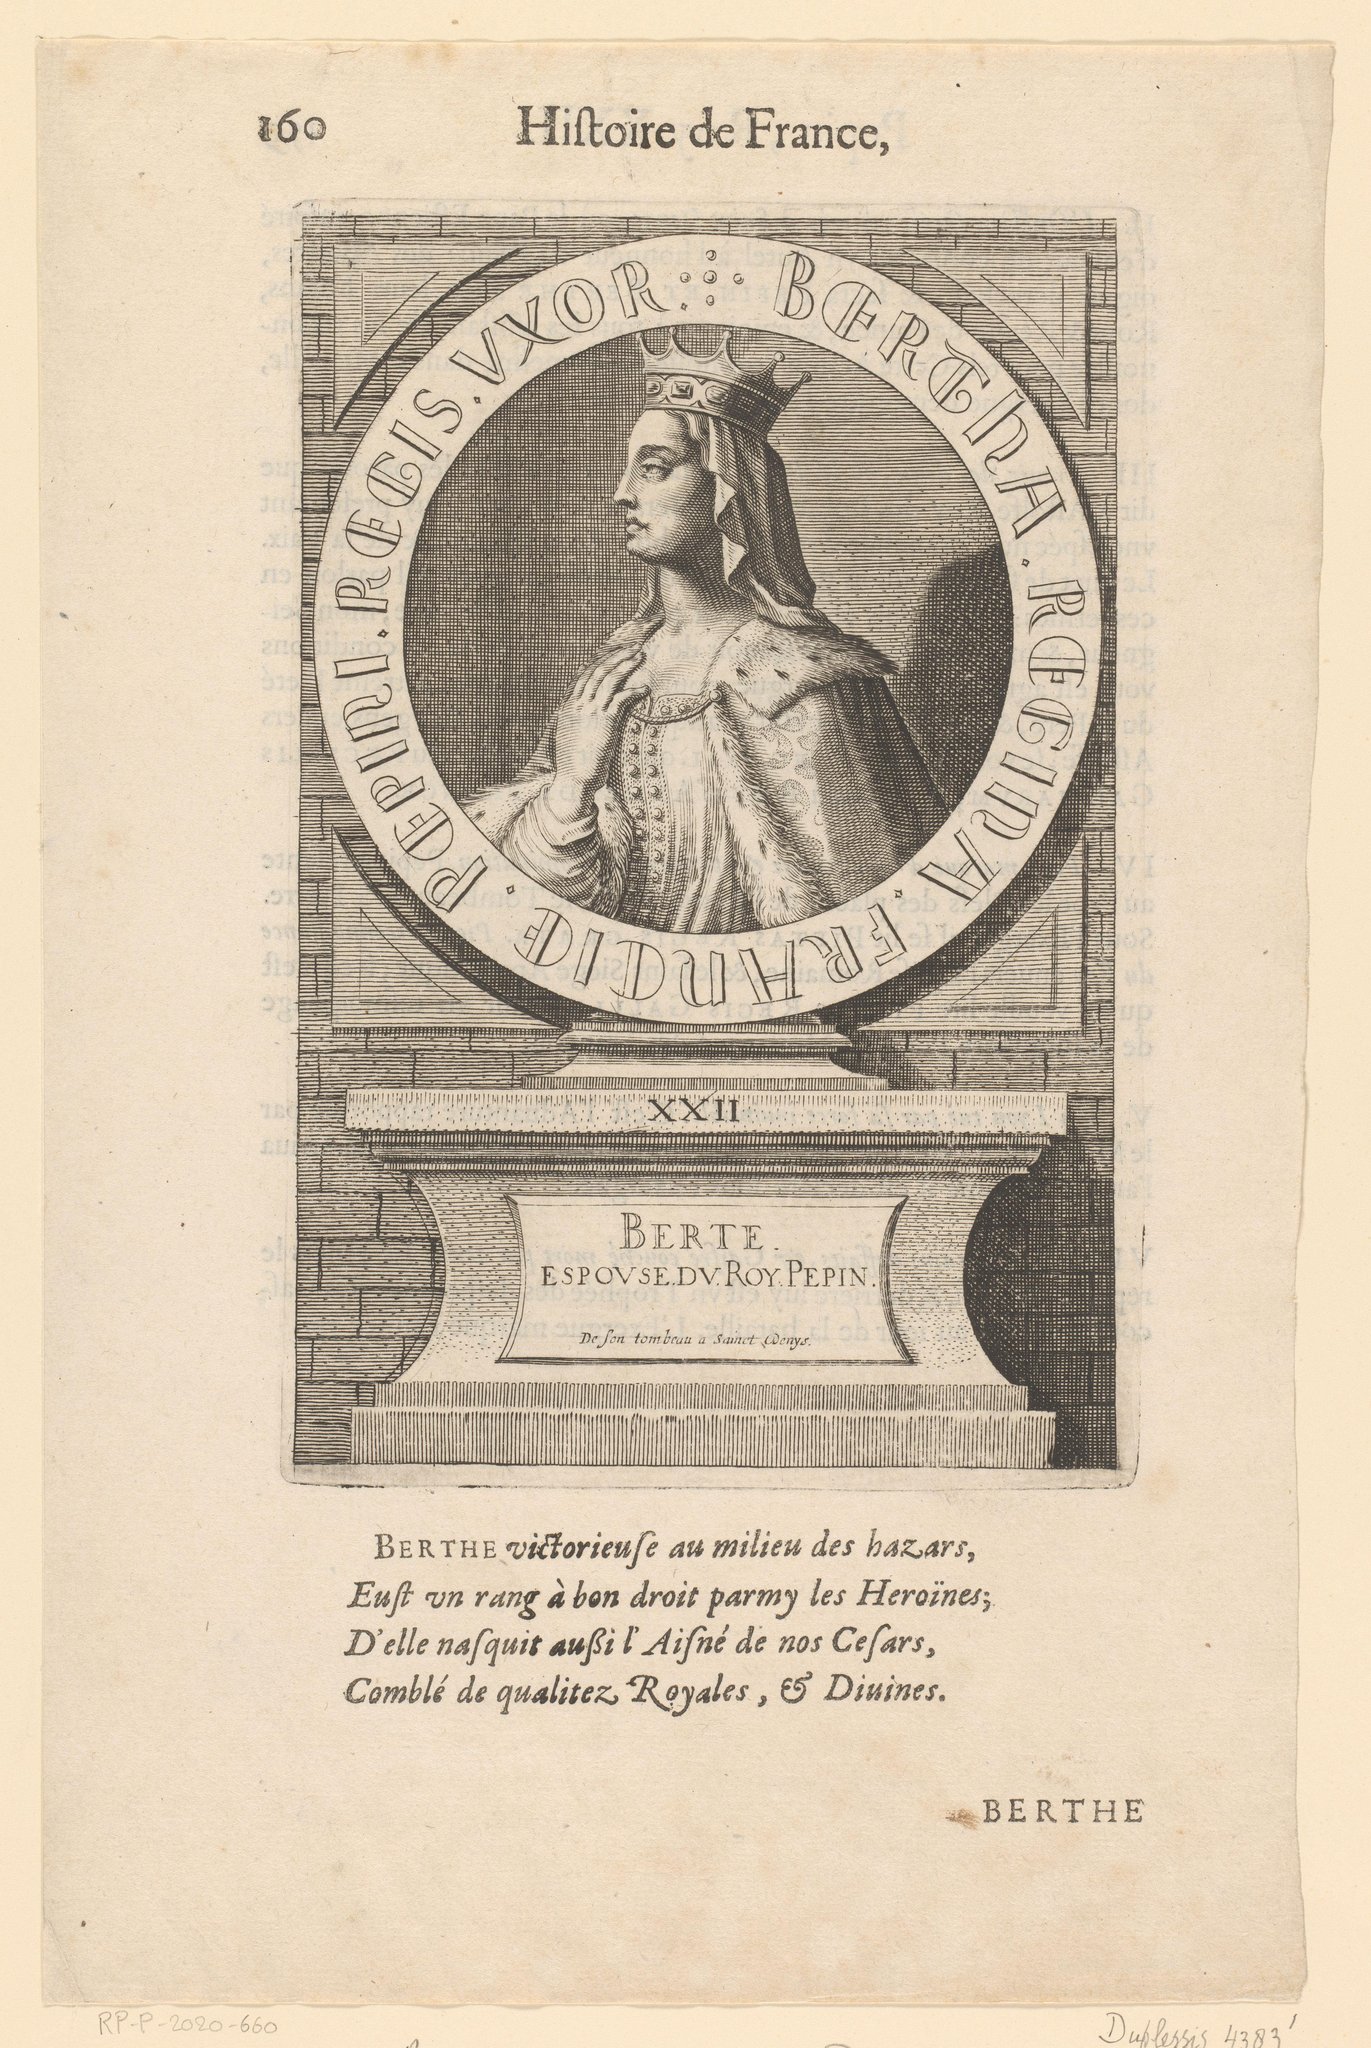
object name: print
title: Berte espouse du roy Pepin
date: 1643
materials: paper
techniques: engraving, letterpress printing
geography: paris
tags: historical persons, queen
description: Prent uit: Eudes de Mézeray, François. Histoire de France, depuis Faramond jusqu’au regne de Louis le Juste (...). 3 dln. Parijs: Mathieu Guillemot, 1643, dl. 1. Prent waarschijnlijk voor het eerst verschenen in: Bie, Jacques de. Les vrais portraits des rois de France (...). Parijs: Jacques de Bie en Pierre Rocolet, 1634. Prent ook gebruikt in latere publicaties.